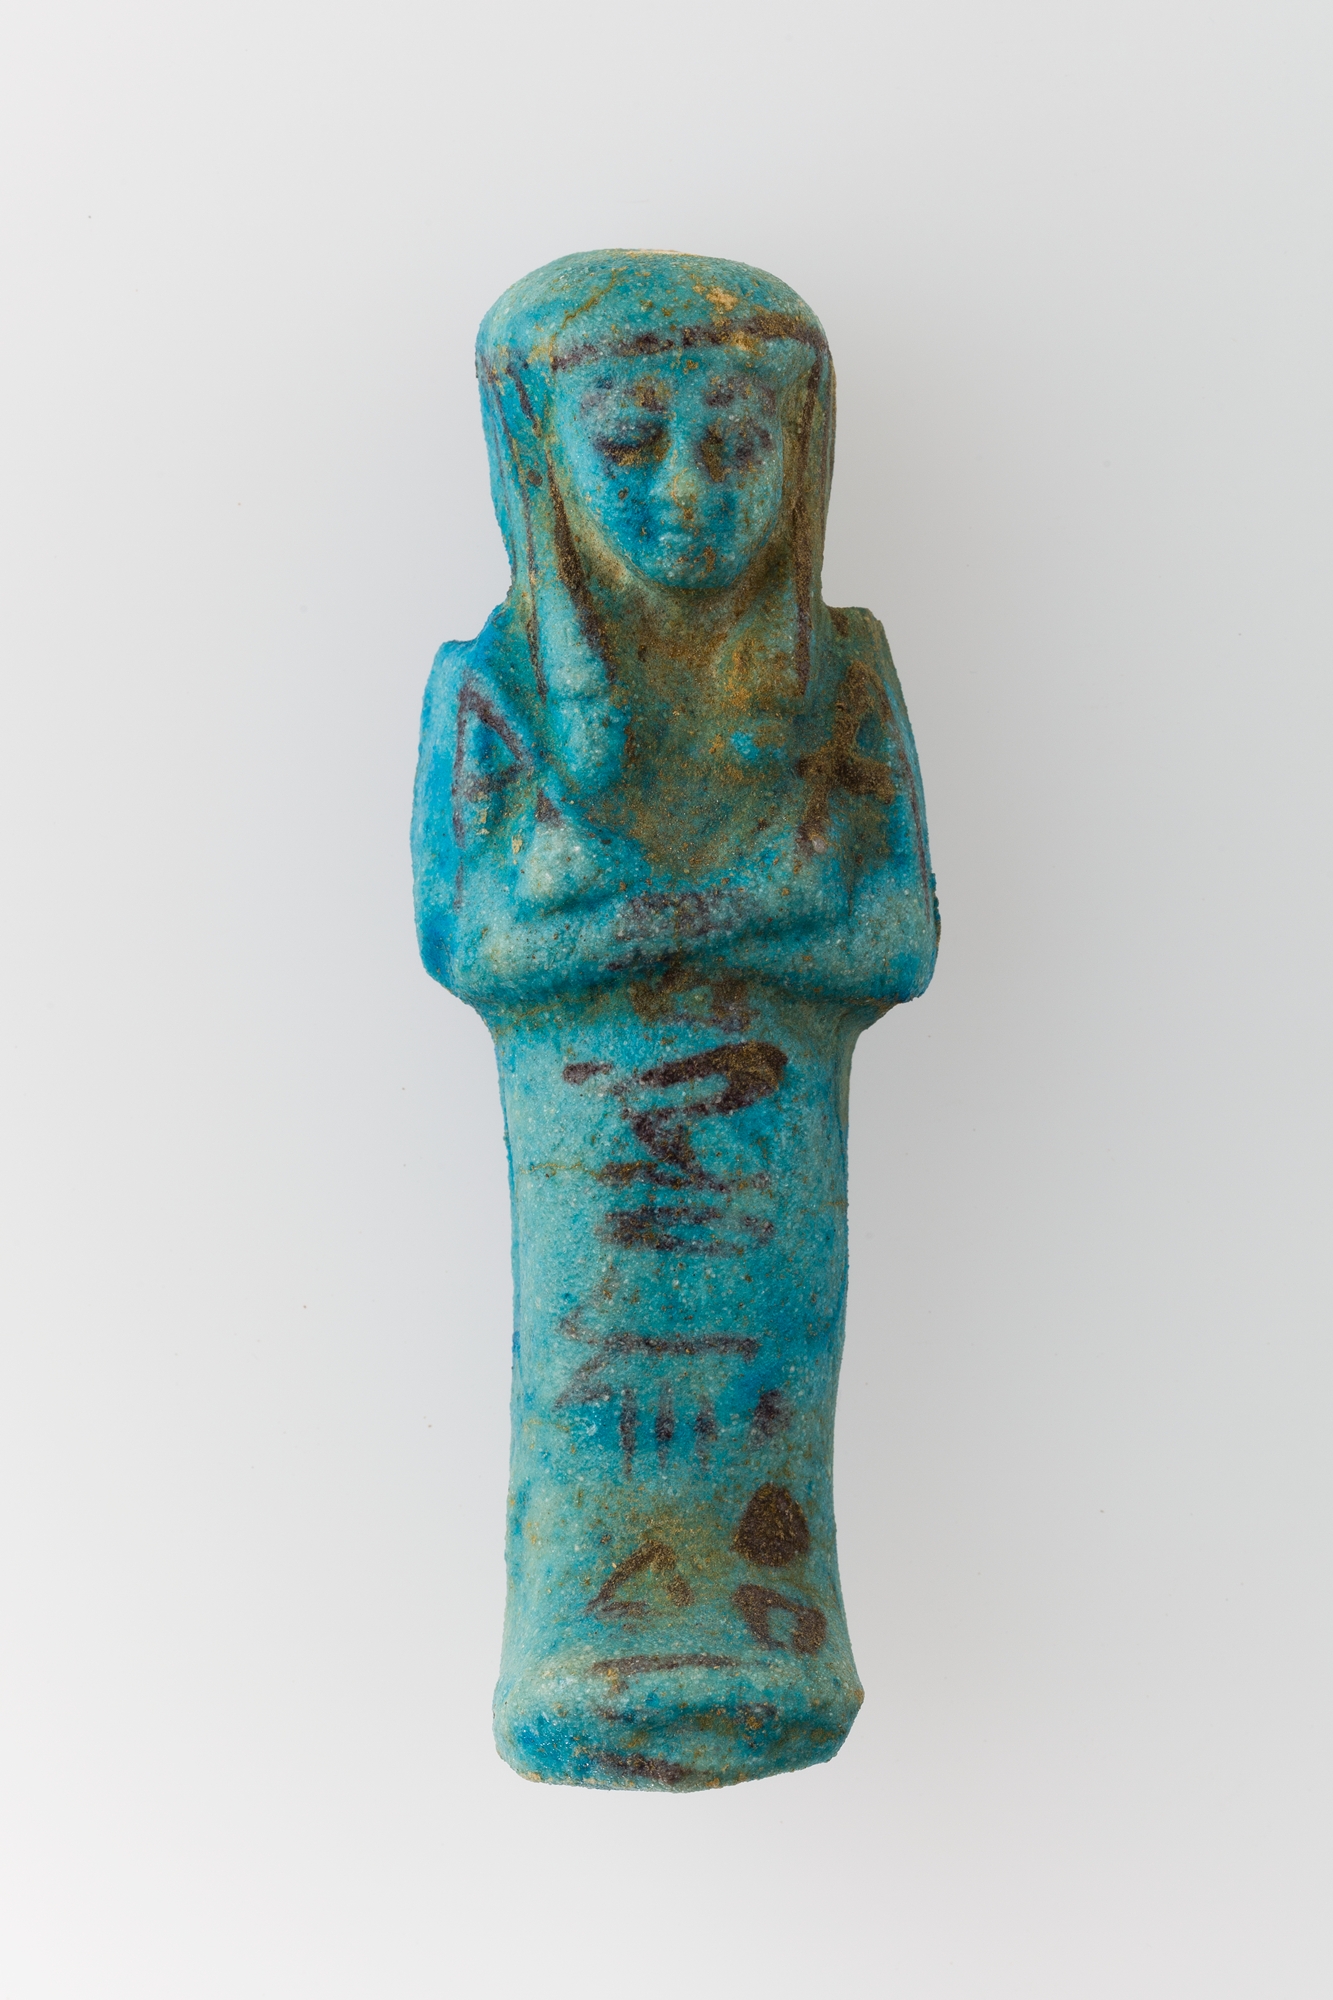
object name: shabti, henettawy c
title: Worker Shabti of Henettawy (C), Daughter of Isetemkheb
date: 990-970 BCE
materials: faience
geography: egypt